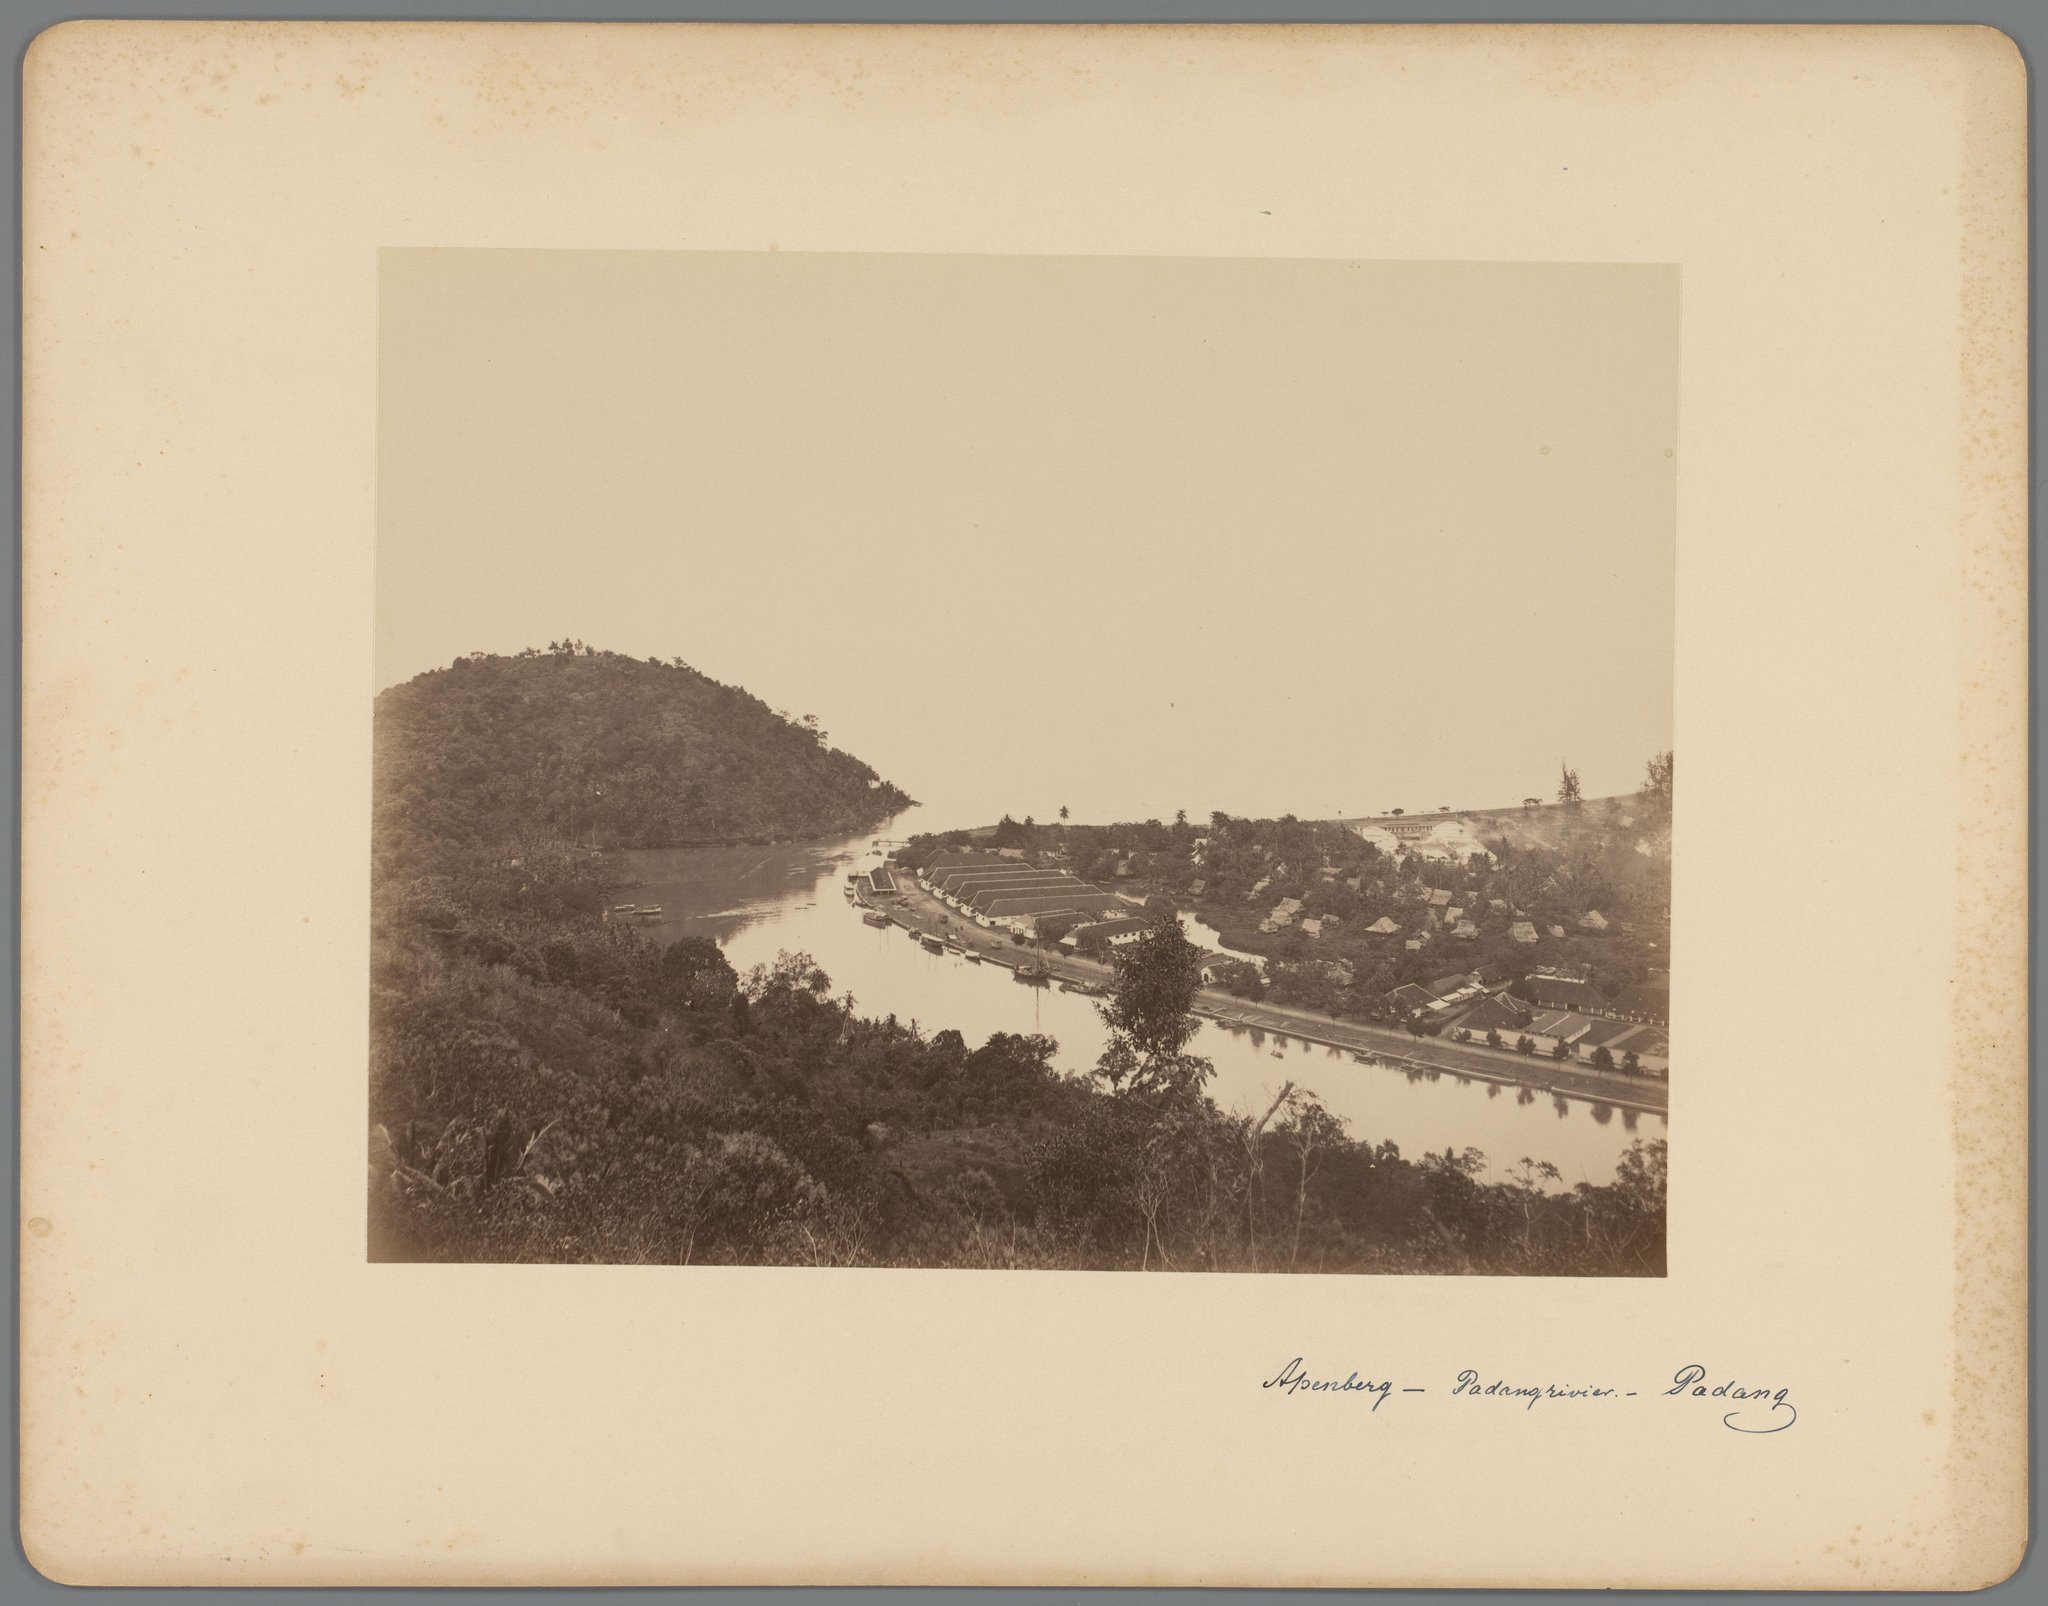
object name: photograph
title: Gezicht op de Apenberg en de monding van de Padang-rivier, Padang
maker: christiaan benjamin nieuwenhuis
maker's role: publisher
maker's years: 1863-1922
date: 1891-1895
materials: cardboard, paper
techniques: albumen print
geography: padang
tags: gulf, bay, river mouth, estuary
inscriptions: inscription: ‘Foto’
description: Deze foto zat oorspronkelijk in prentenkabinet RP-F-AA3192.